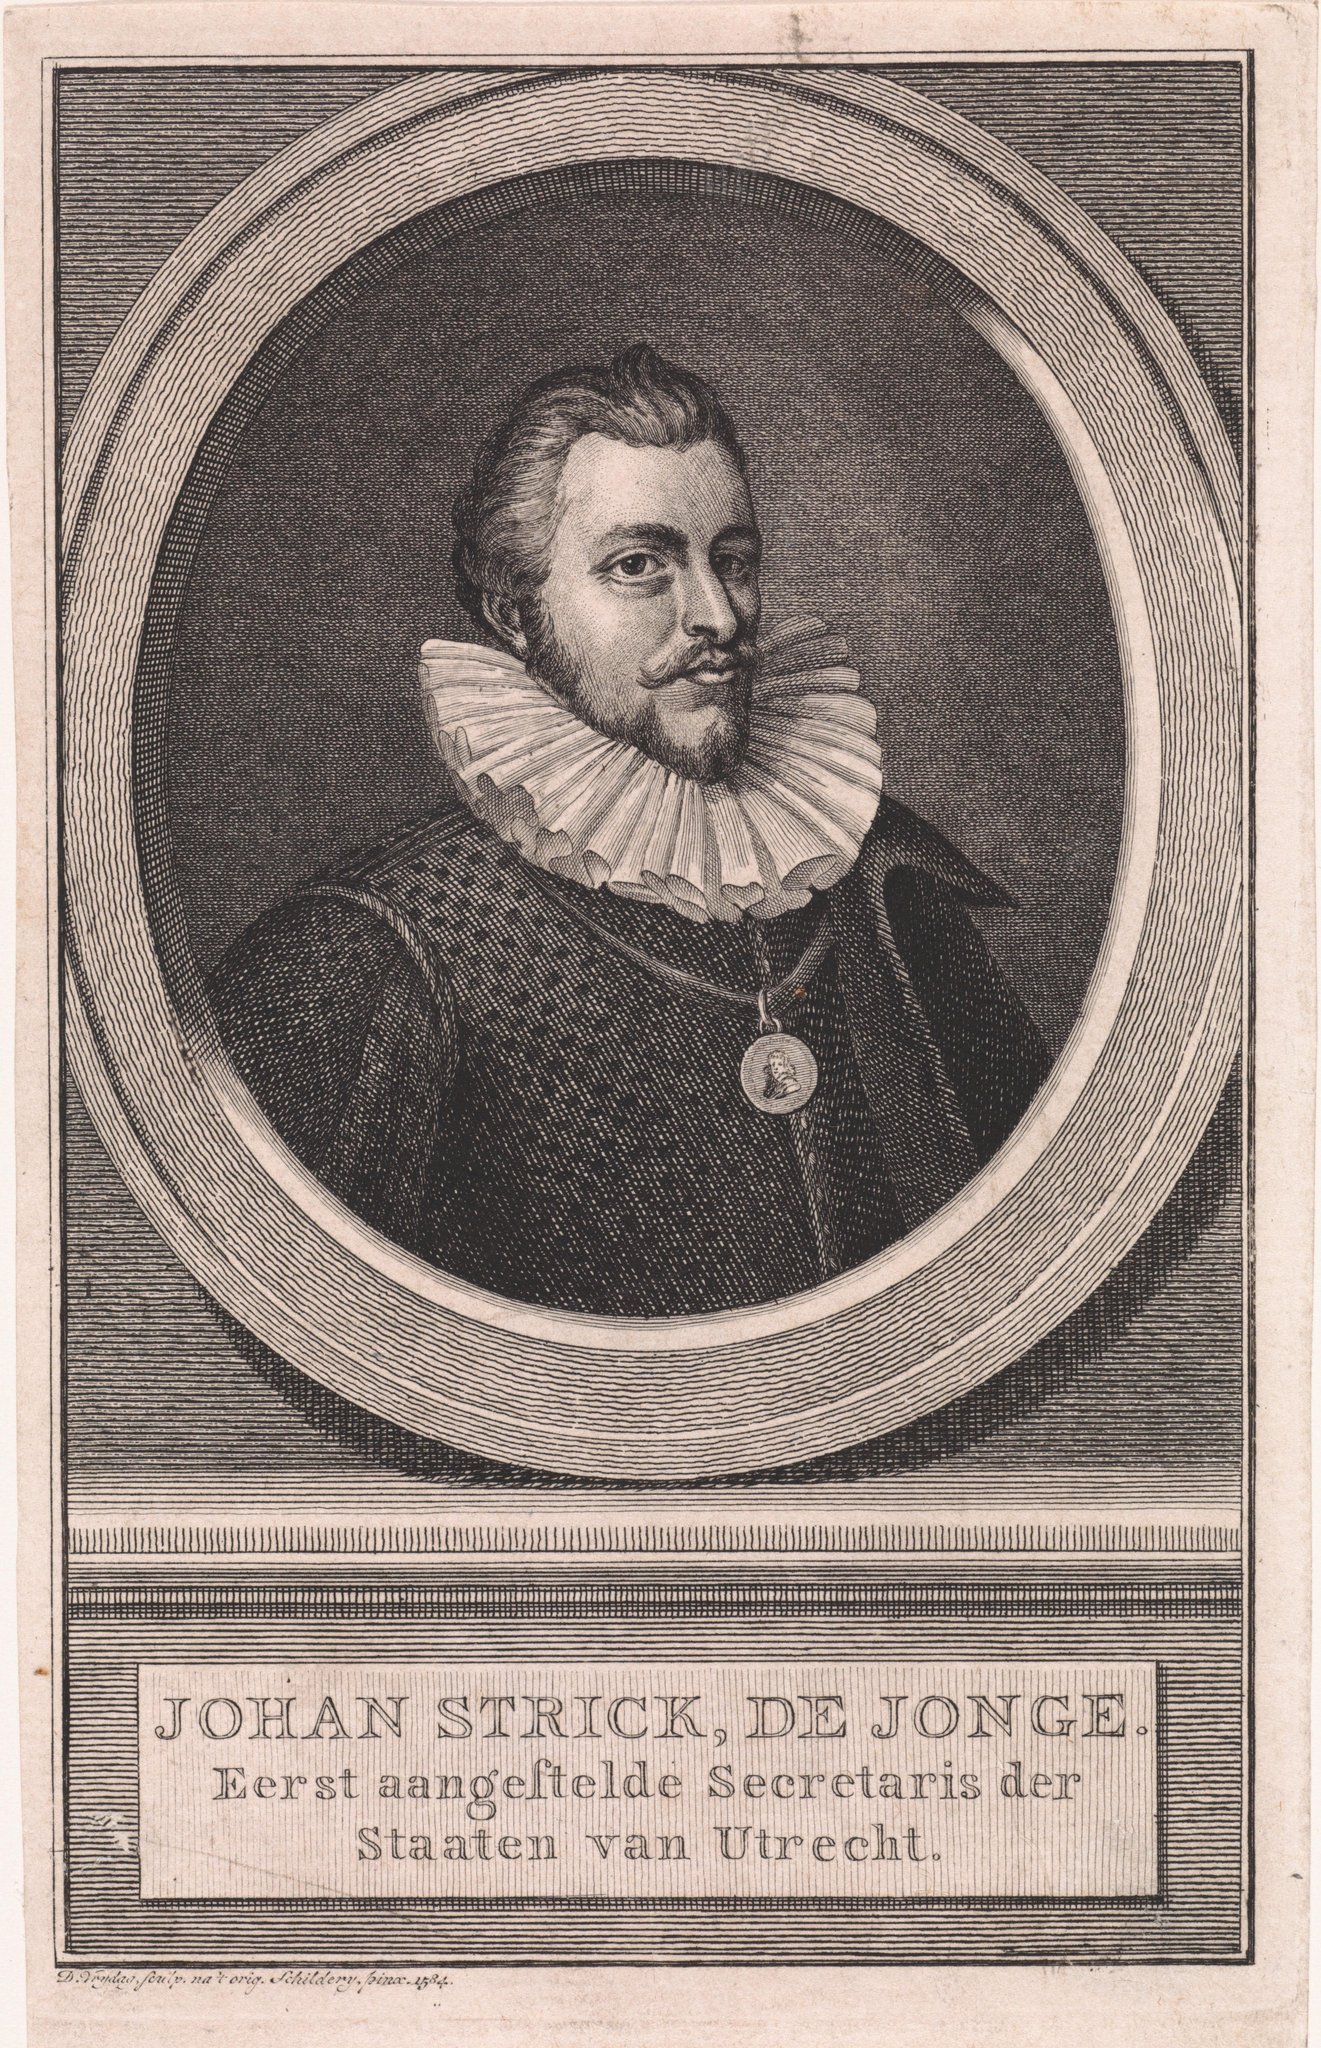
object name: print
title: Portret van Johan Strick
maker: daniël vrijdag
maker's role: draughtsman, print maker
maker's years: 1765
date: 1775-1822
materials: paper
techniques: engraving, etching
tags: pendant, trinket, 'breloque'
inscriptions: collector's mark: Lugt 2228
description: Portret van Johan Strick de Jonge, eerste secretaris van de Staten van Utrecht. Om zijn hals een medaillon met een portret van een man.